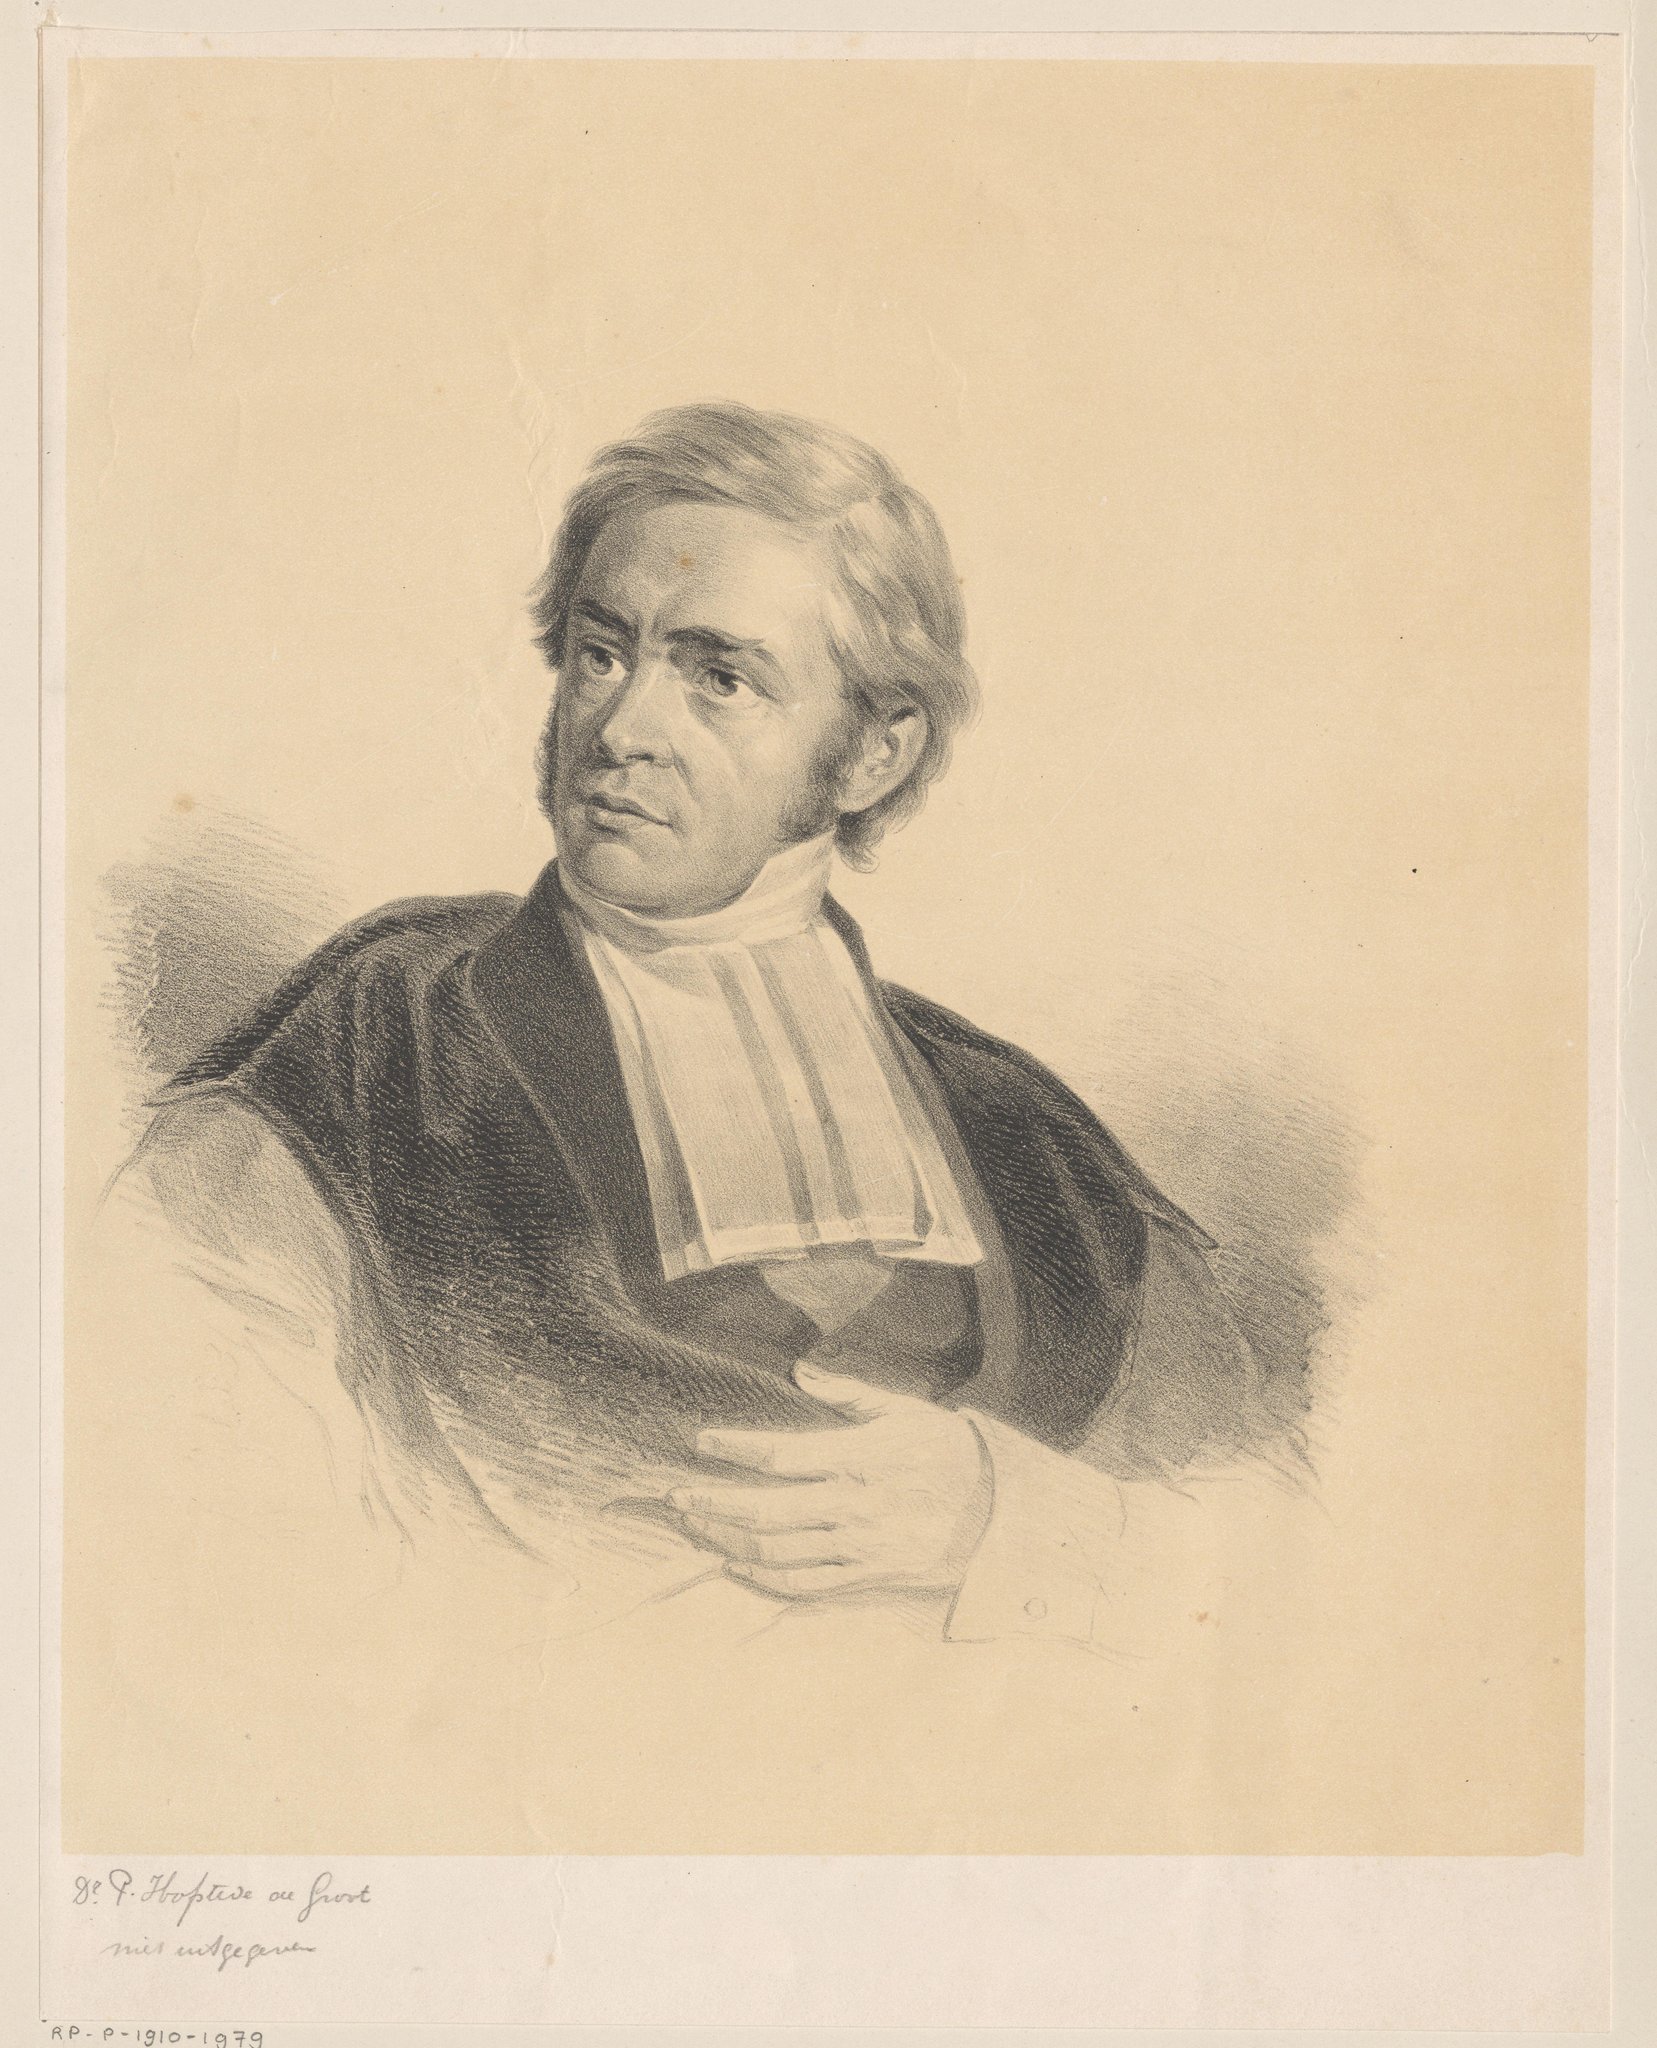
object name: print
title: Portret van Petrus Hofstede de Groot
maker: Anonymous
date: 1829-1853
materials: paper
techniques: tone lithography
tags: historical persons, professor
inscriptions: collector's mark: Lugt 2228